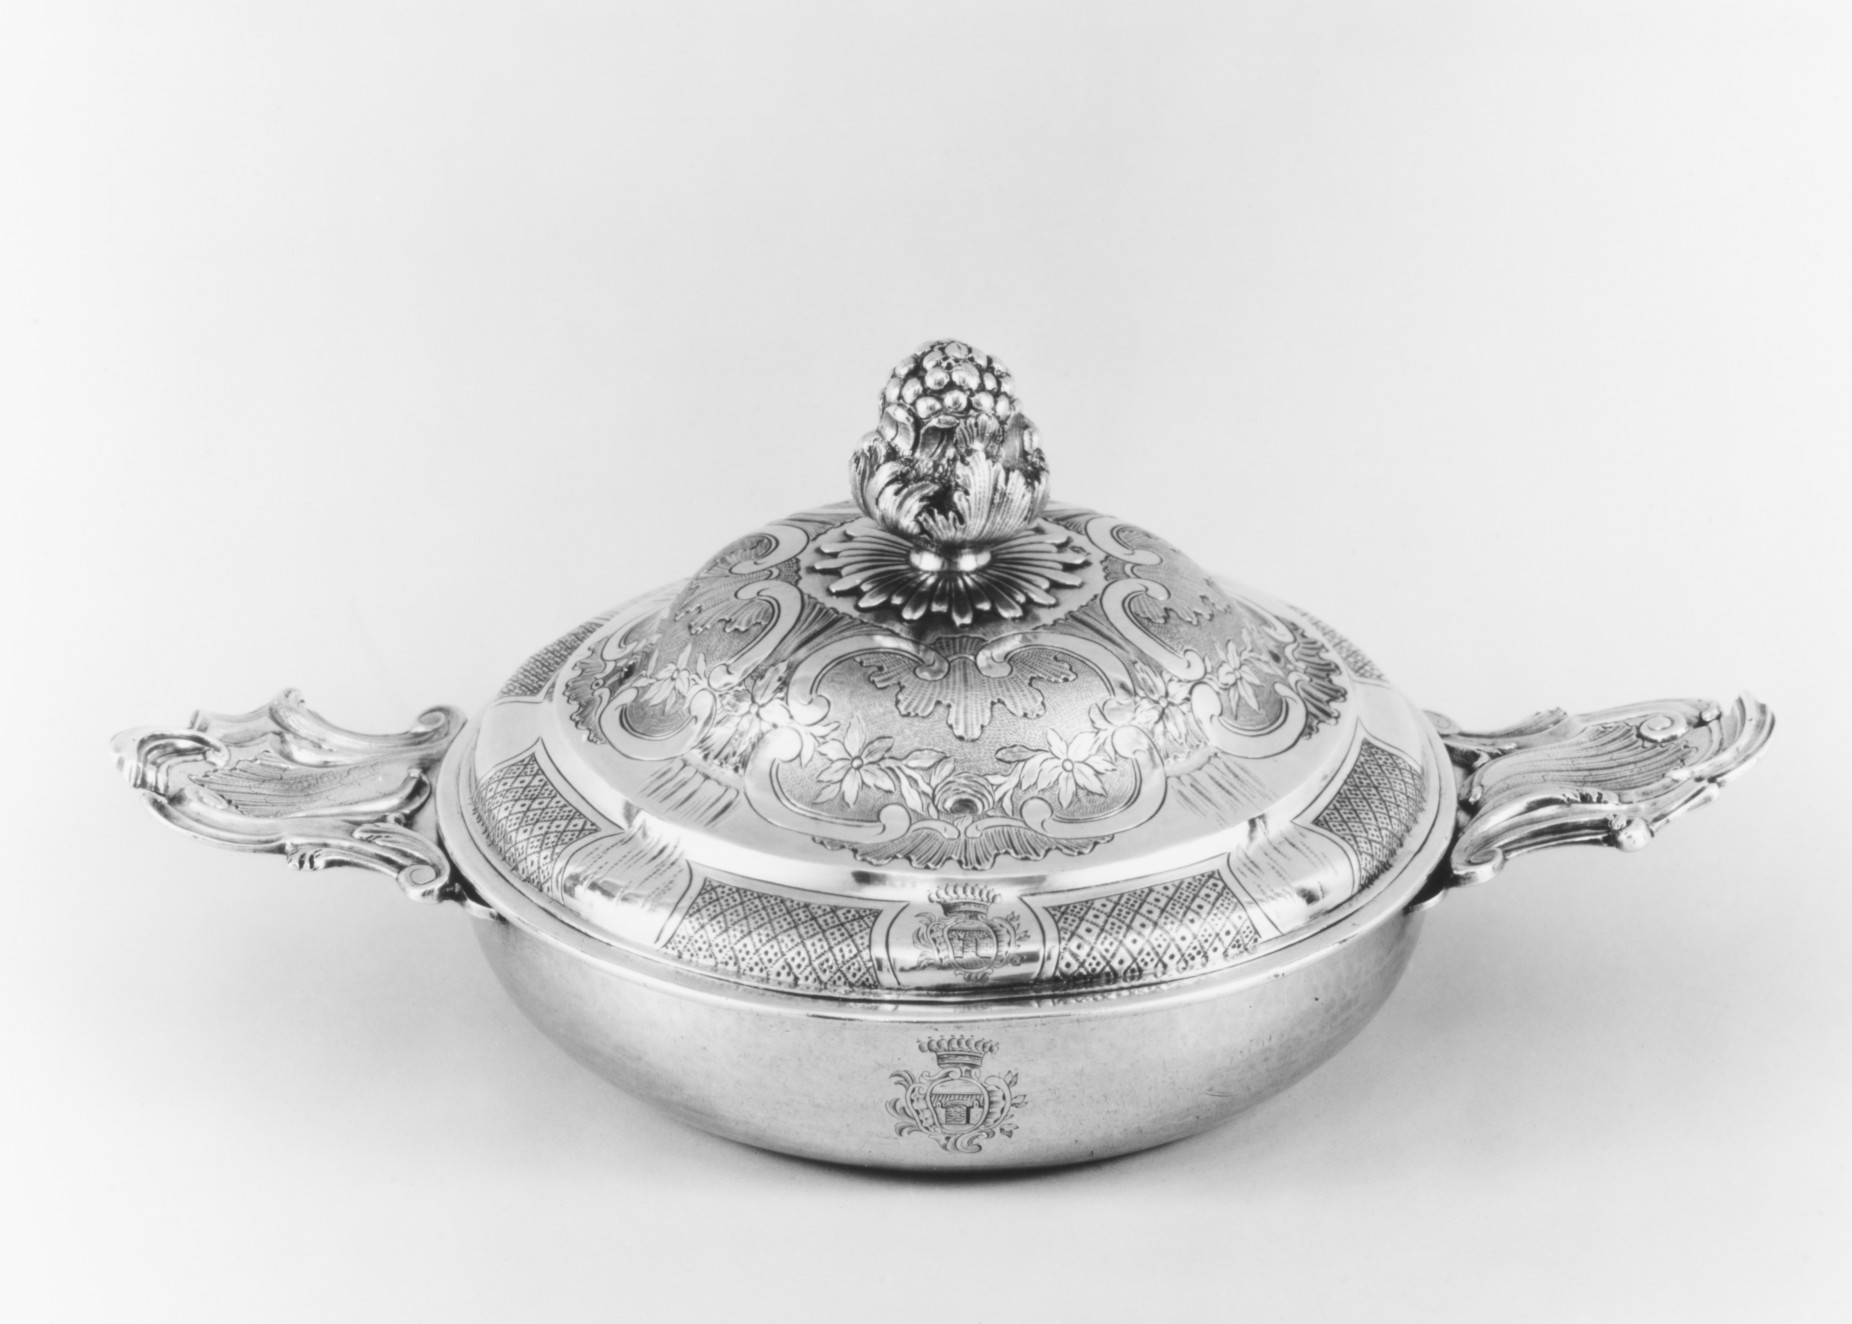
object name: porringer with cover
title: Porringer with cover (Écuelle)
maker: philippe lafourge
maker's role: maker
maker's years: 1667-1767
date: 1759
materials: silver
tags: coat of arms